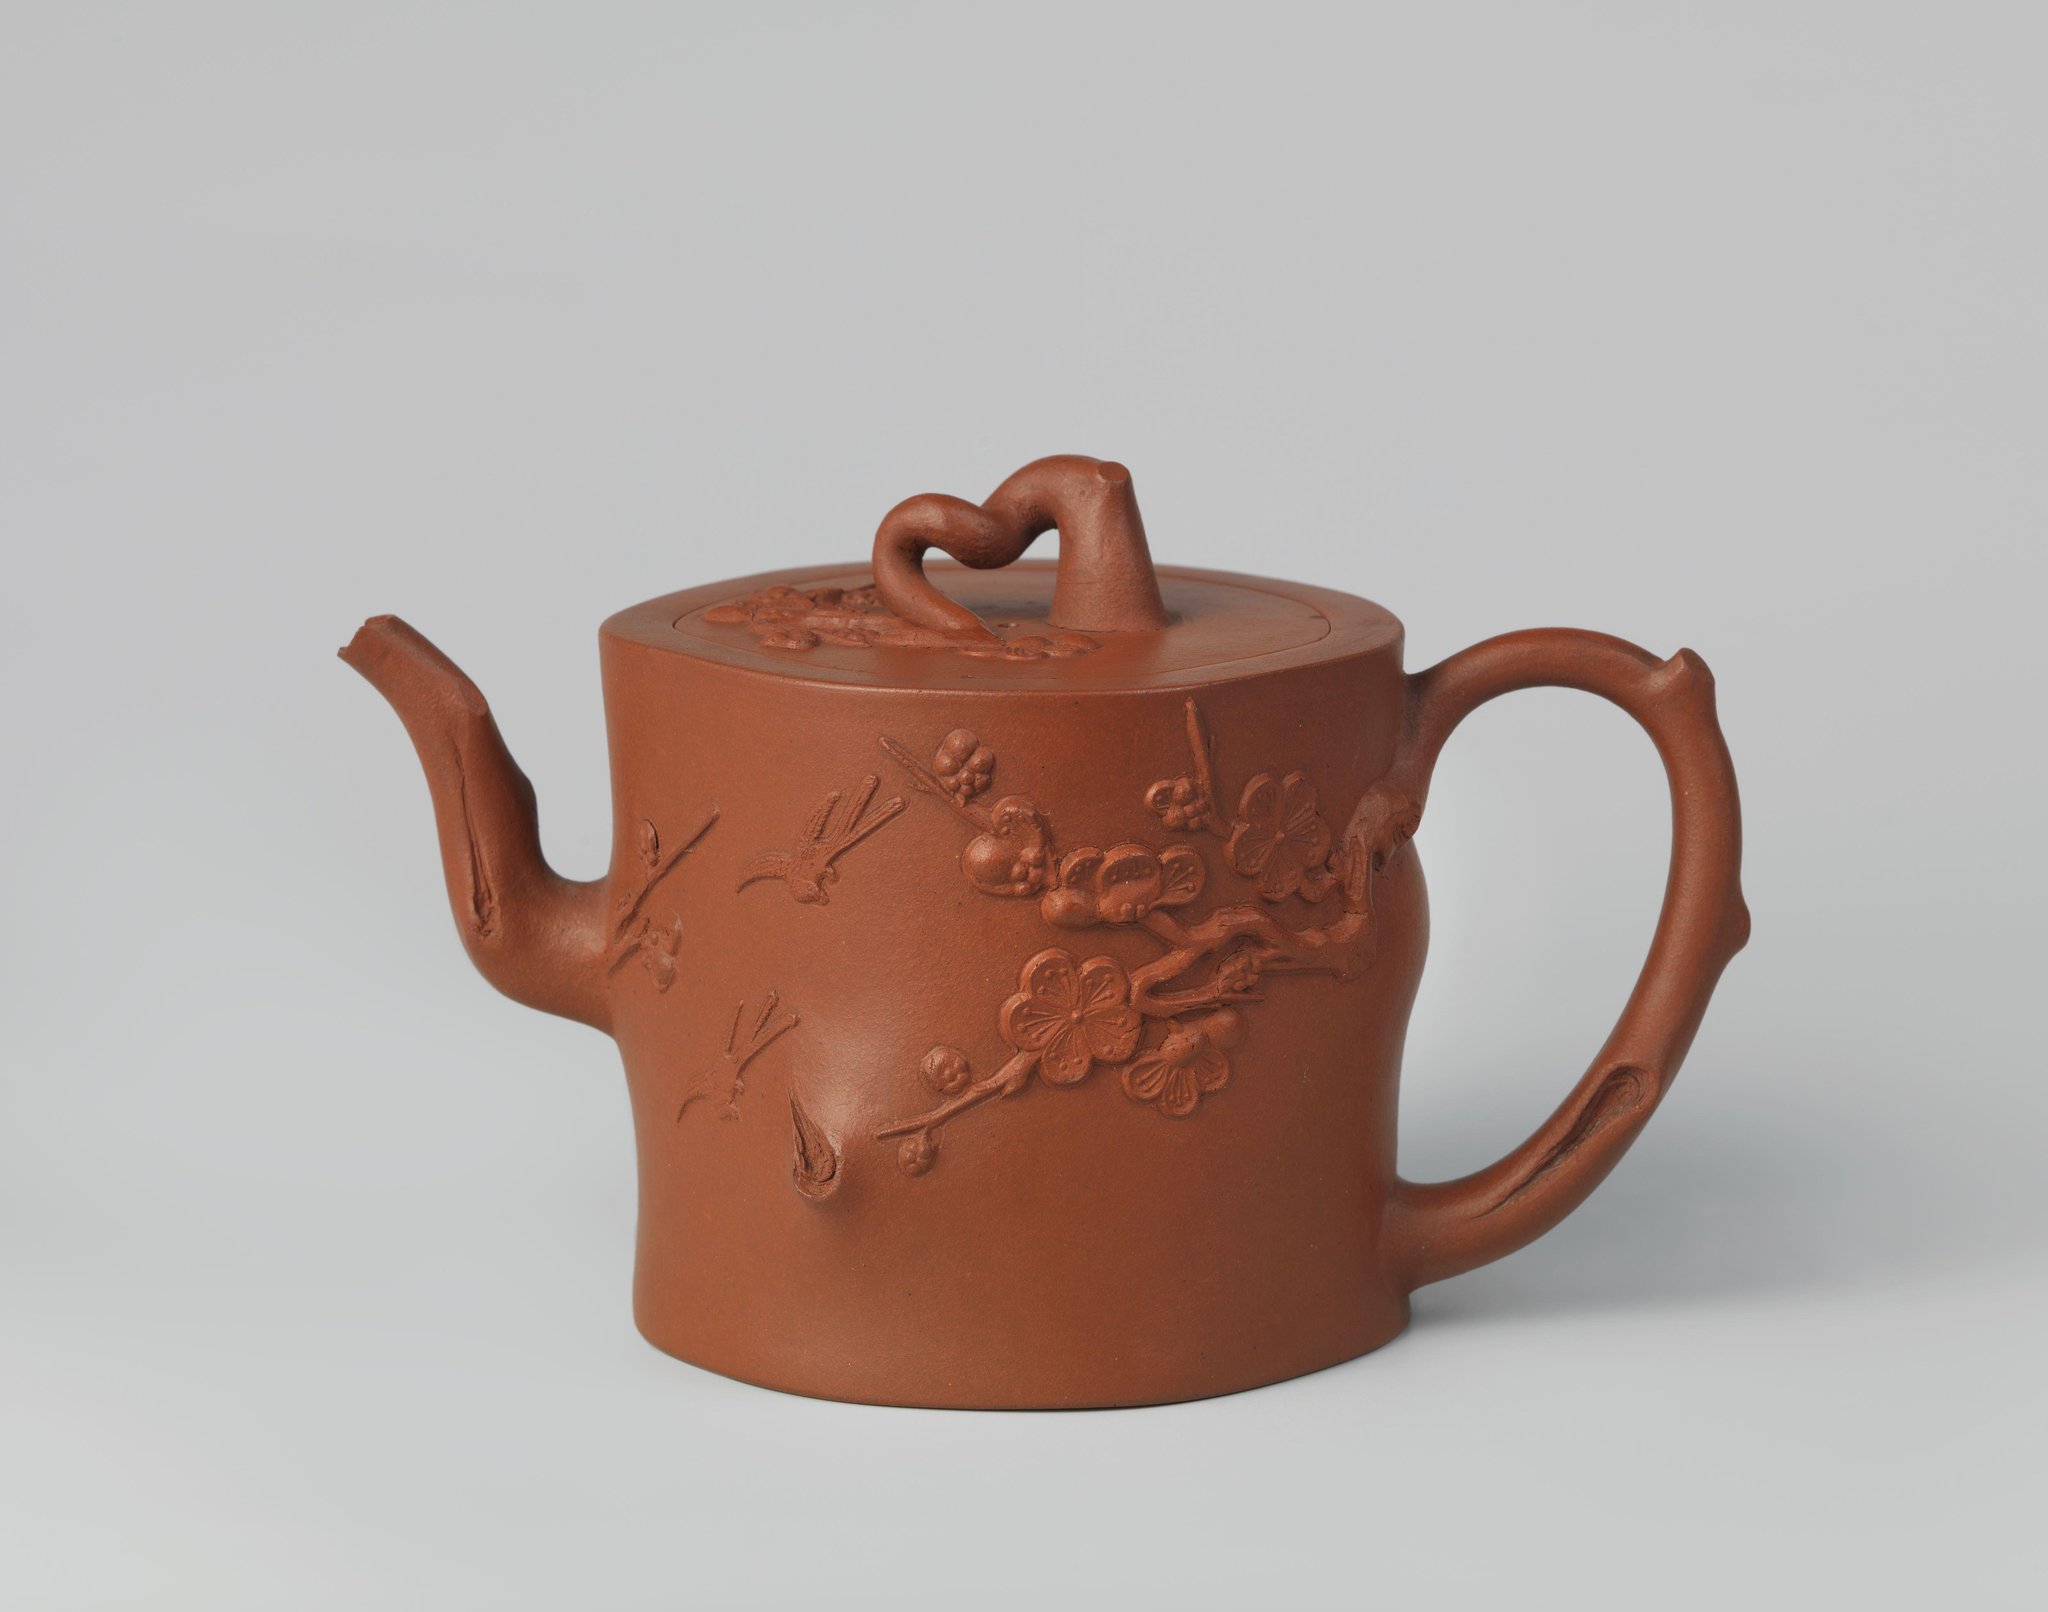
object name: teapot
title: Teapot with prunus sprays, birds and a butterfly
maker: Anonymous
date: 1700-1799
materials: stoneware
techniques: firing, forming, relief, turning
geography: china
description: The body of this teapot imitates the trunk of a plum tree. In Chinese culture, the plum blossom is one of the ‘three friends of winter,’ symbolizing the noble spirit. The highly accomplished potters also transformed the teapot’s knop, handle, and spout into prunus branches.